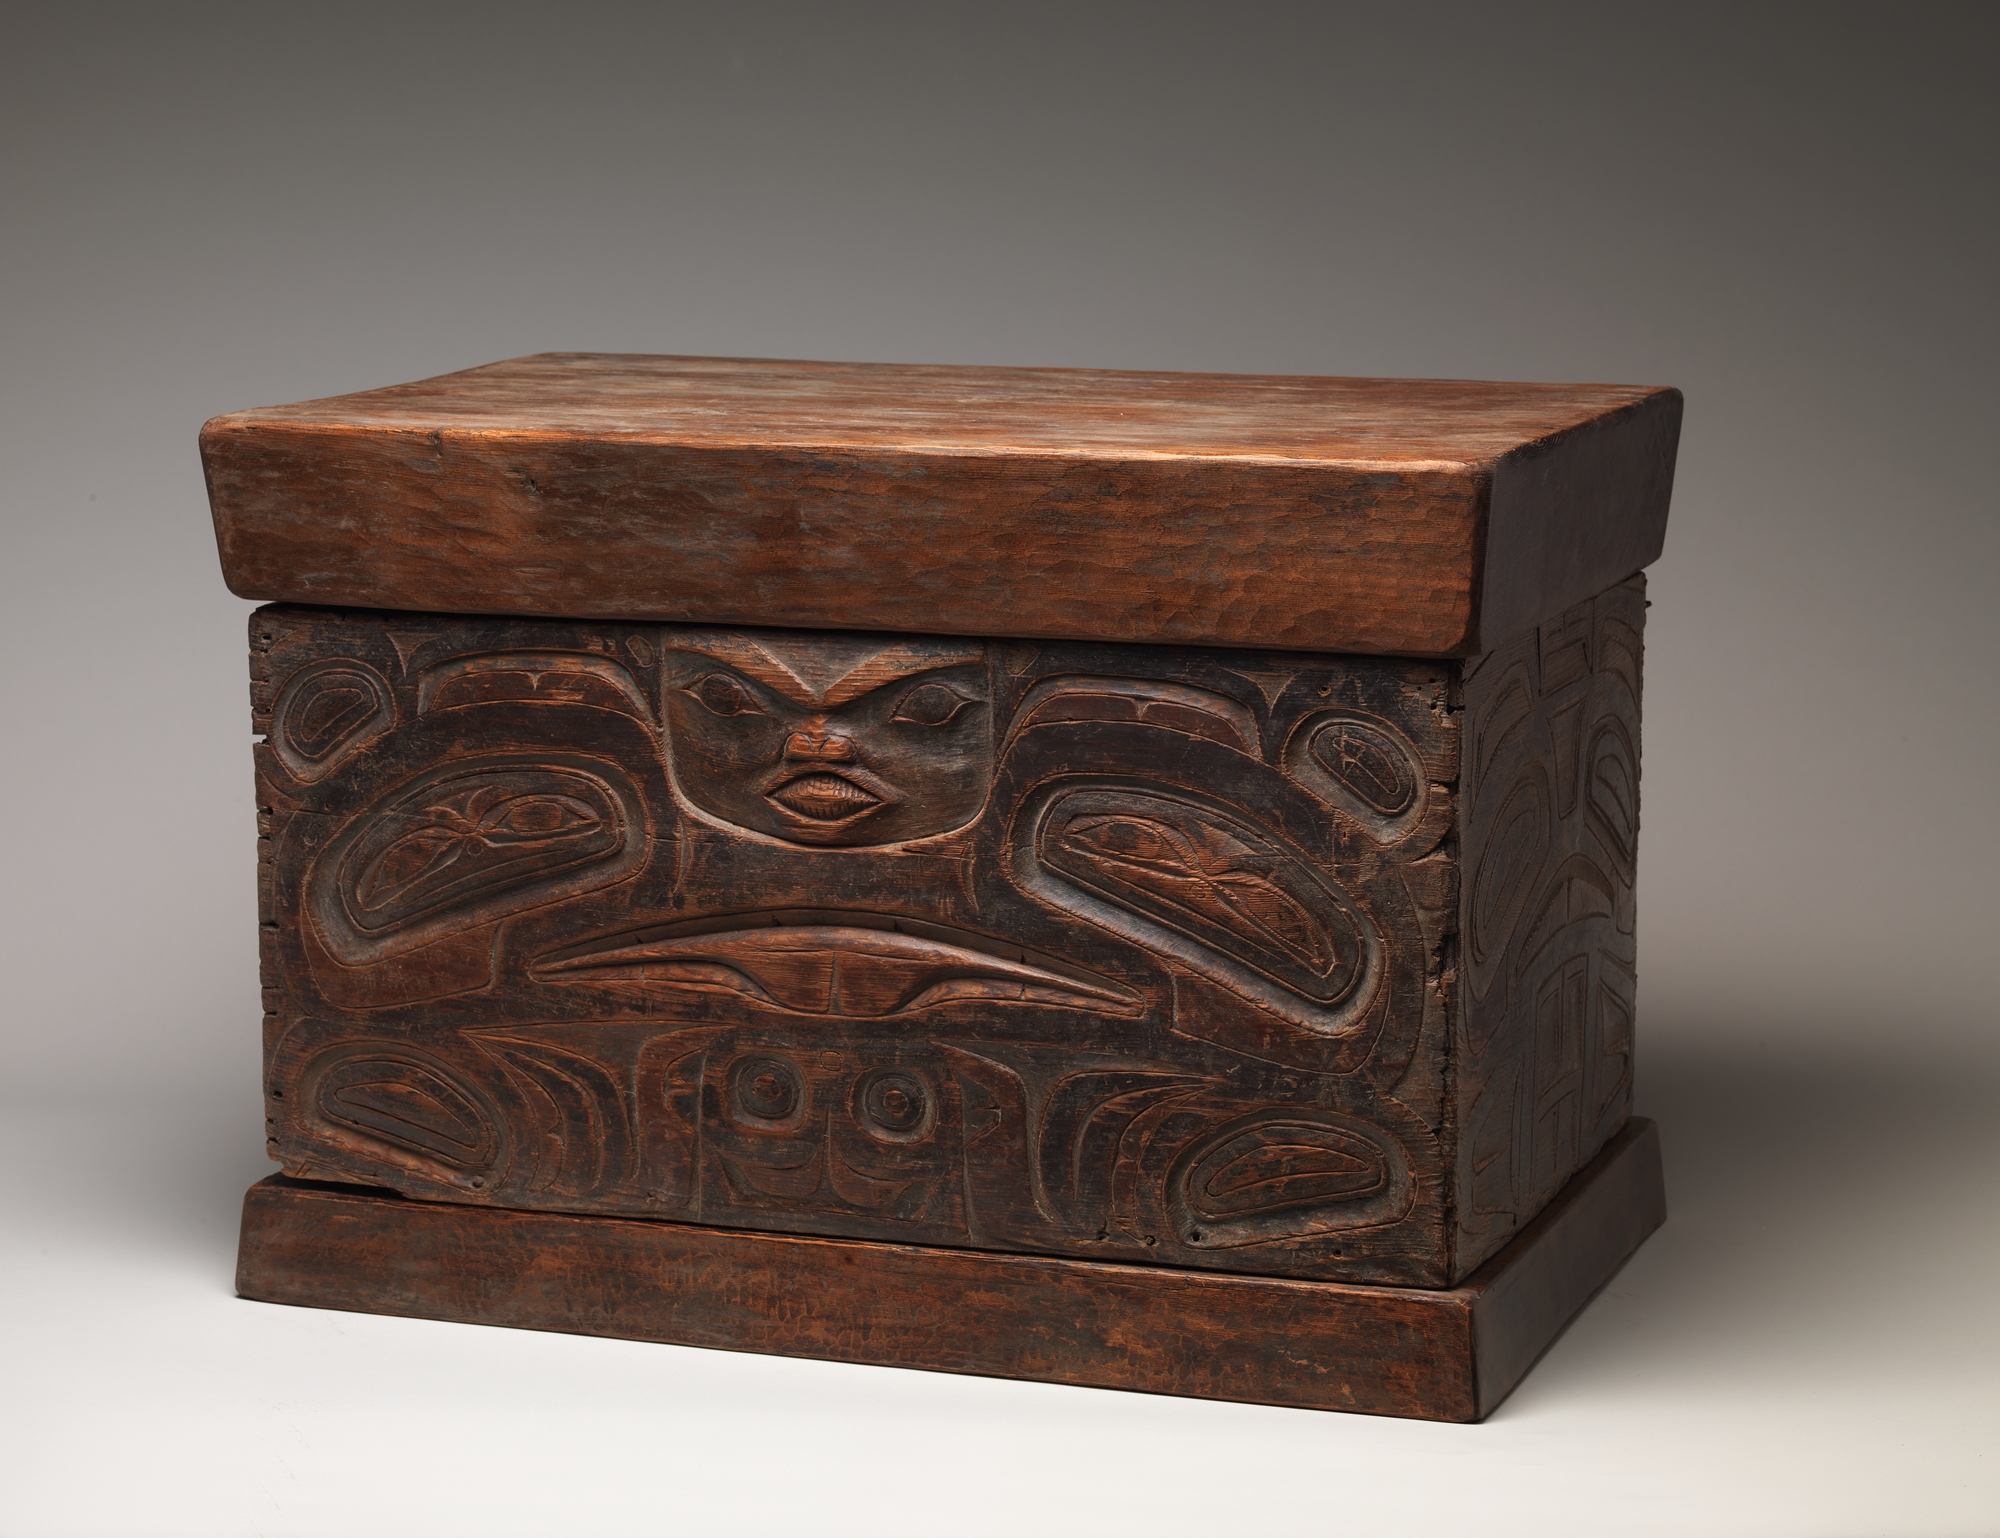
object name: box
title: Storage Chest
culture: tlingit or tsimshian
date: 1780-1820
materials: pigment, wood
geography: united states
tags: faces,chests